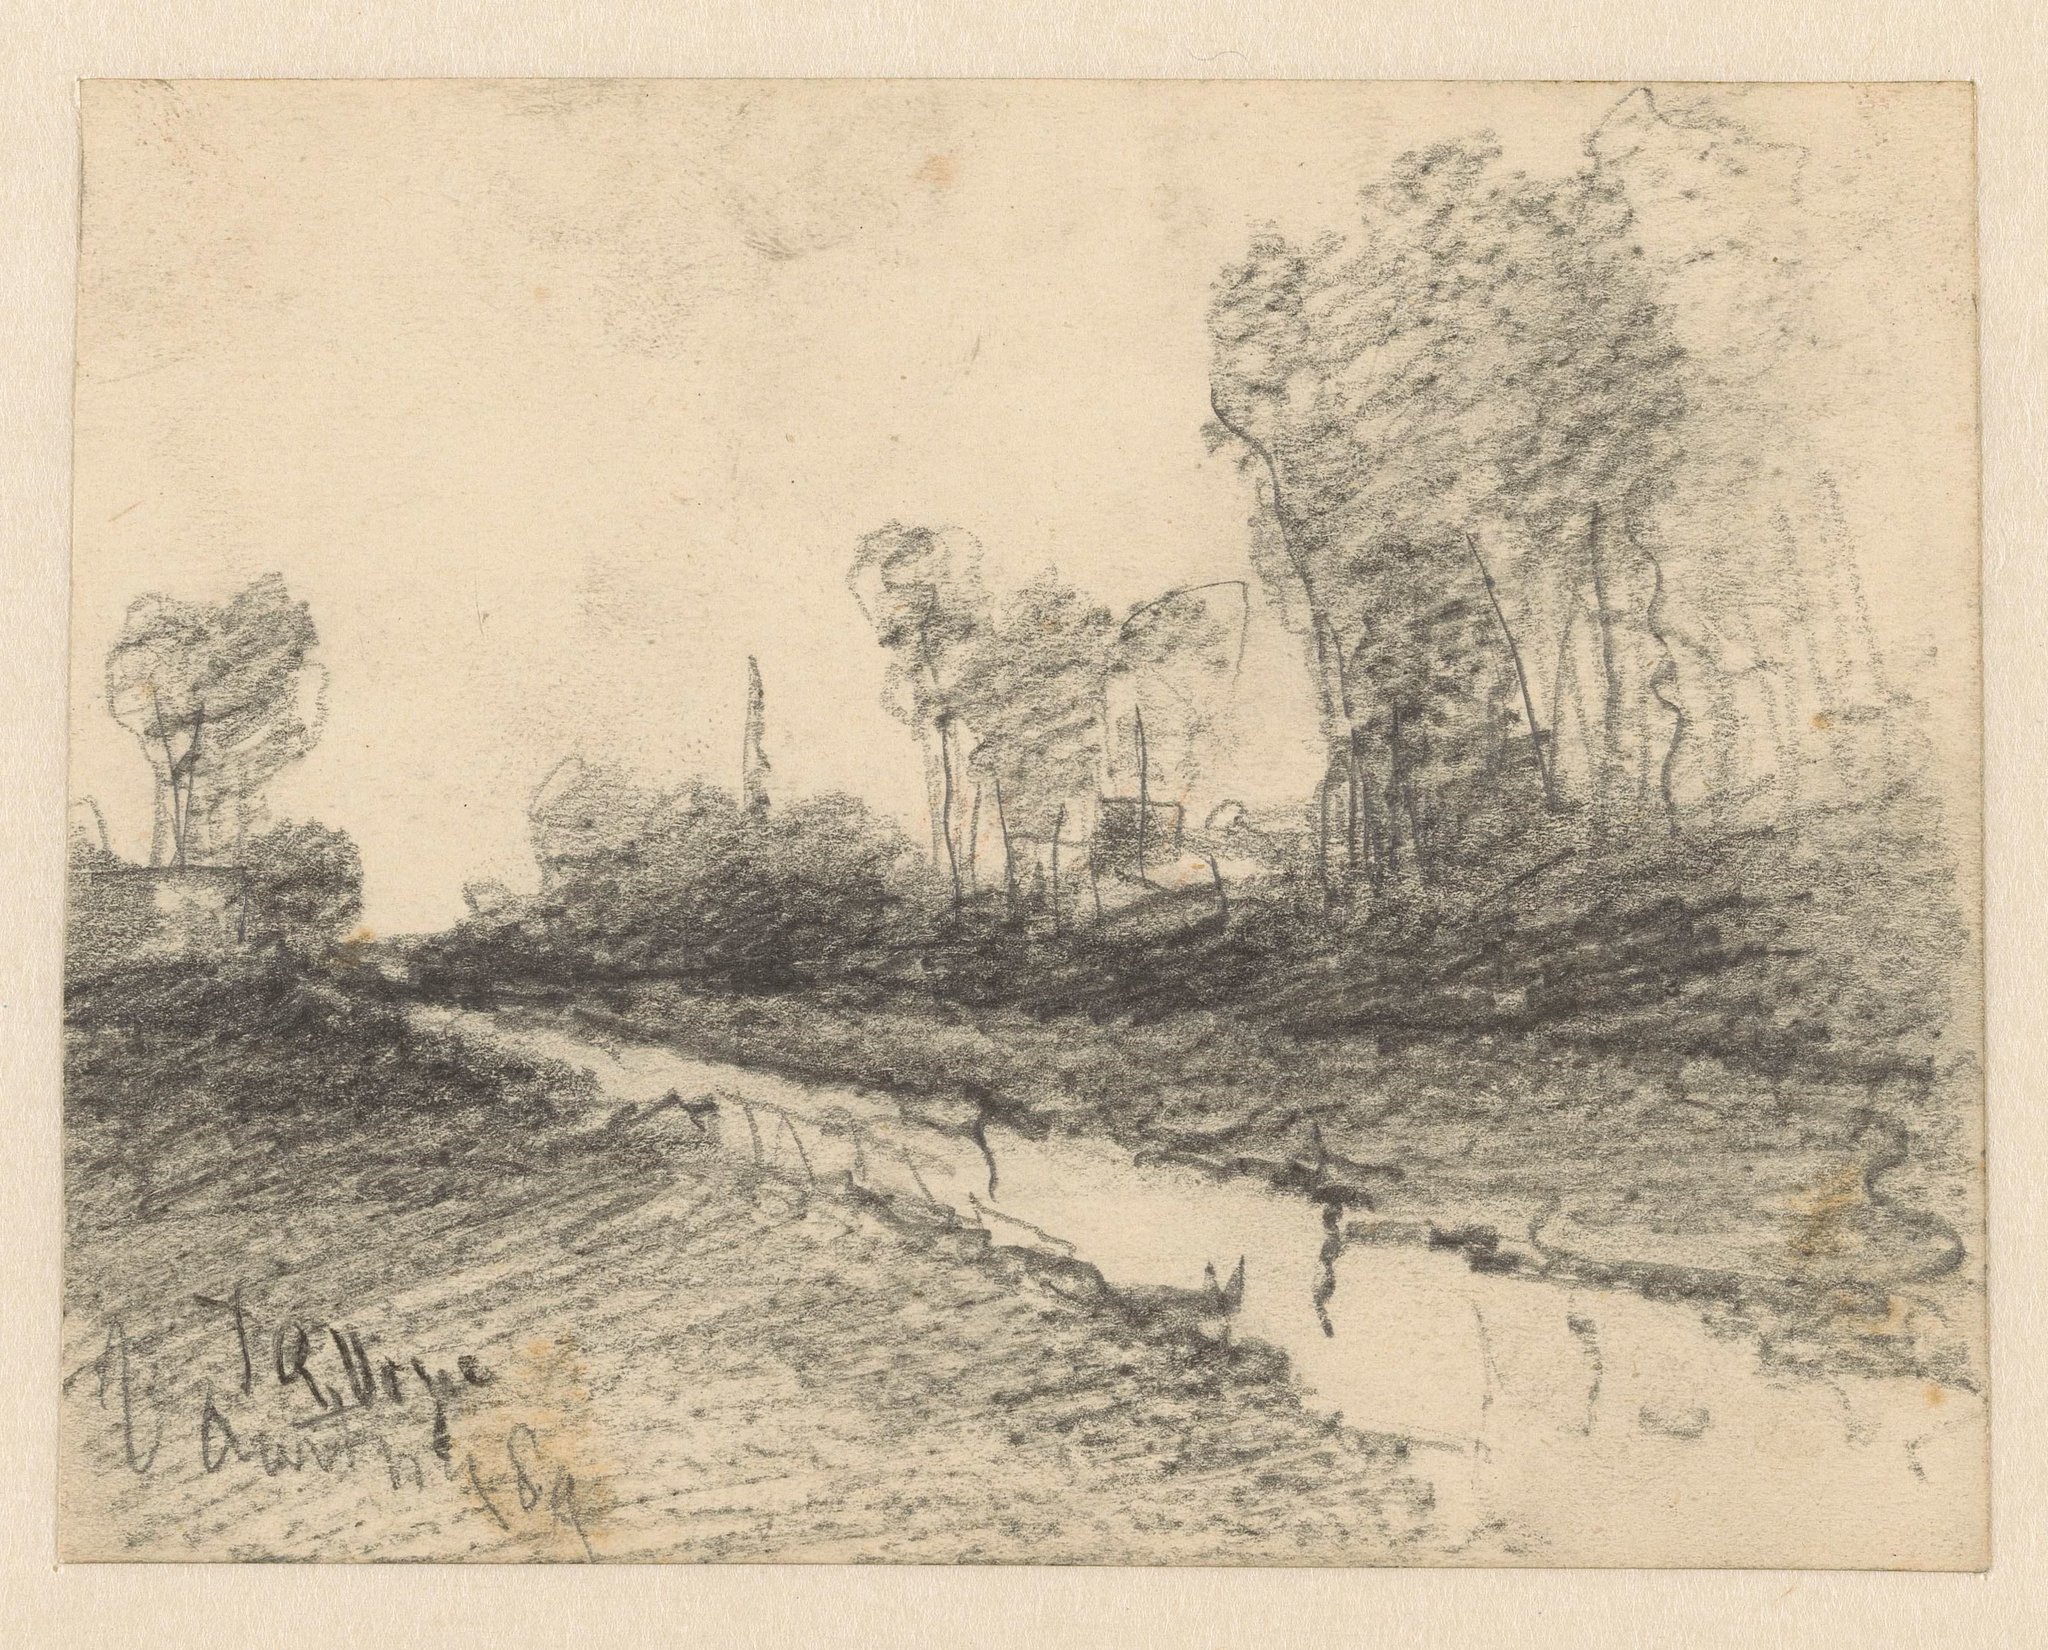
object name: drawing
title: Landschap met vaart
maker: johannes gijsbert vogel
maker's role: draughtsman, painter, print maker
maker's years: 1828-1915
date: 1889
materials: chalk, paper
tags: landscapes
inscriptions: date